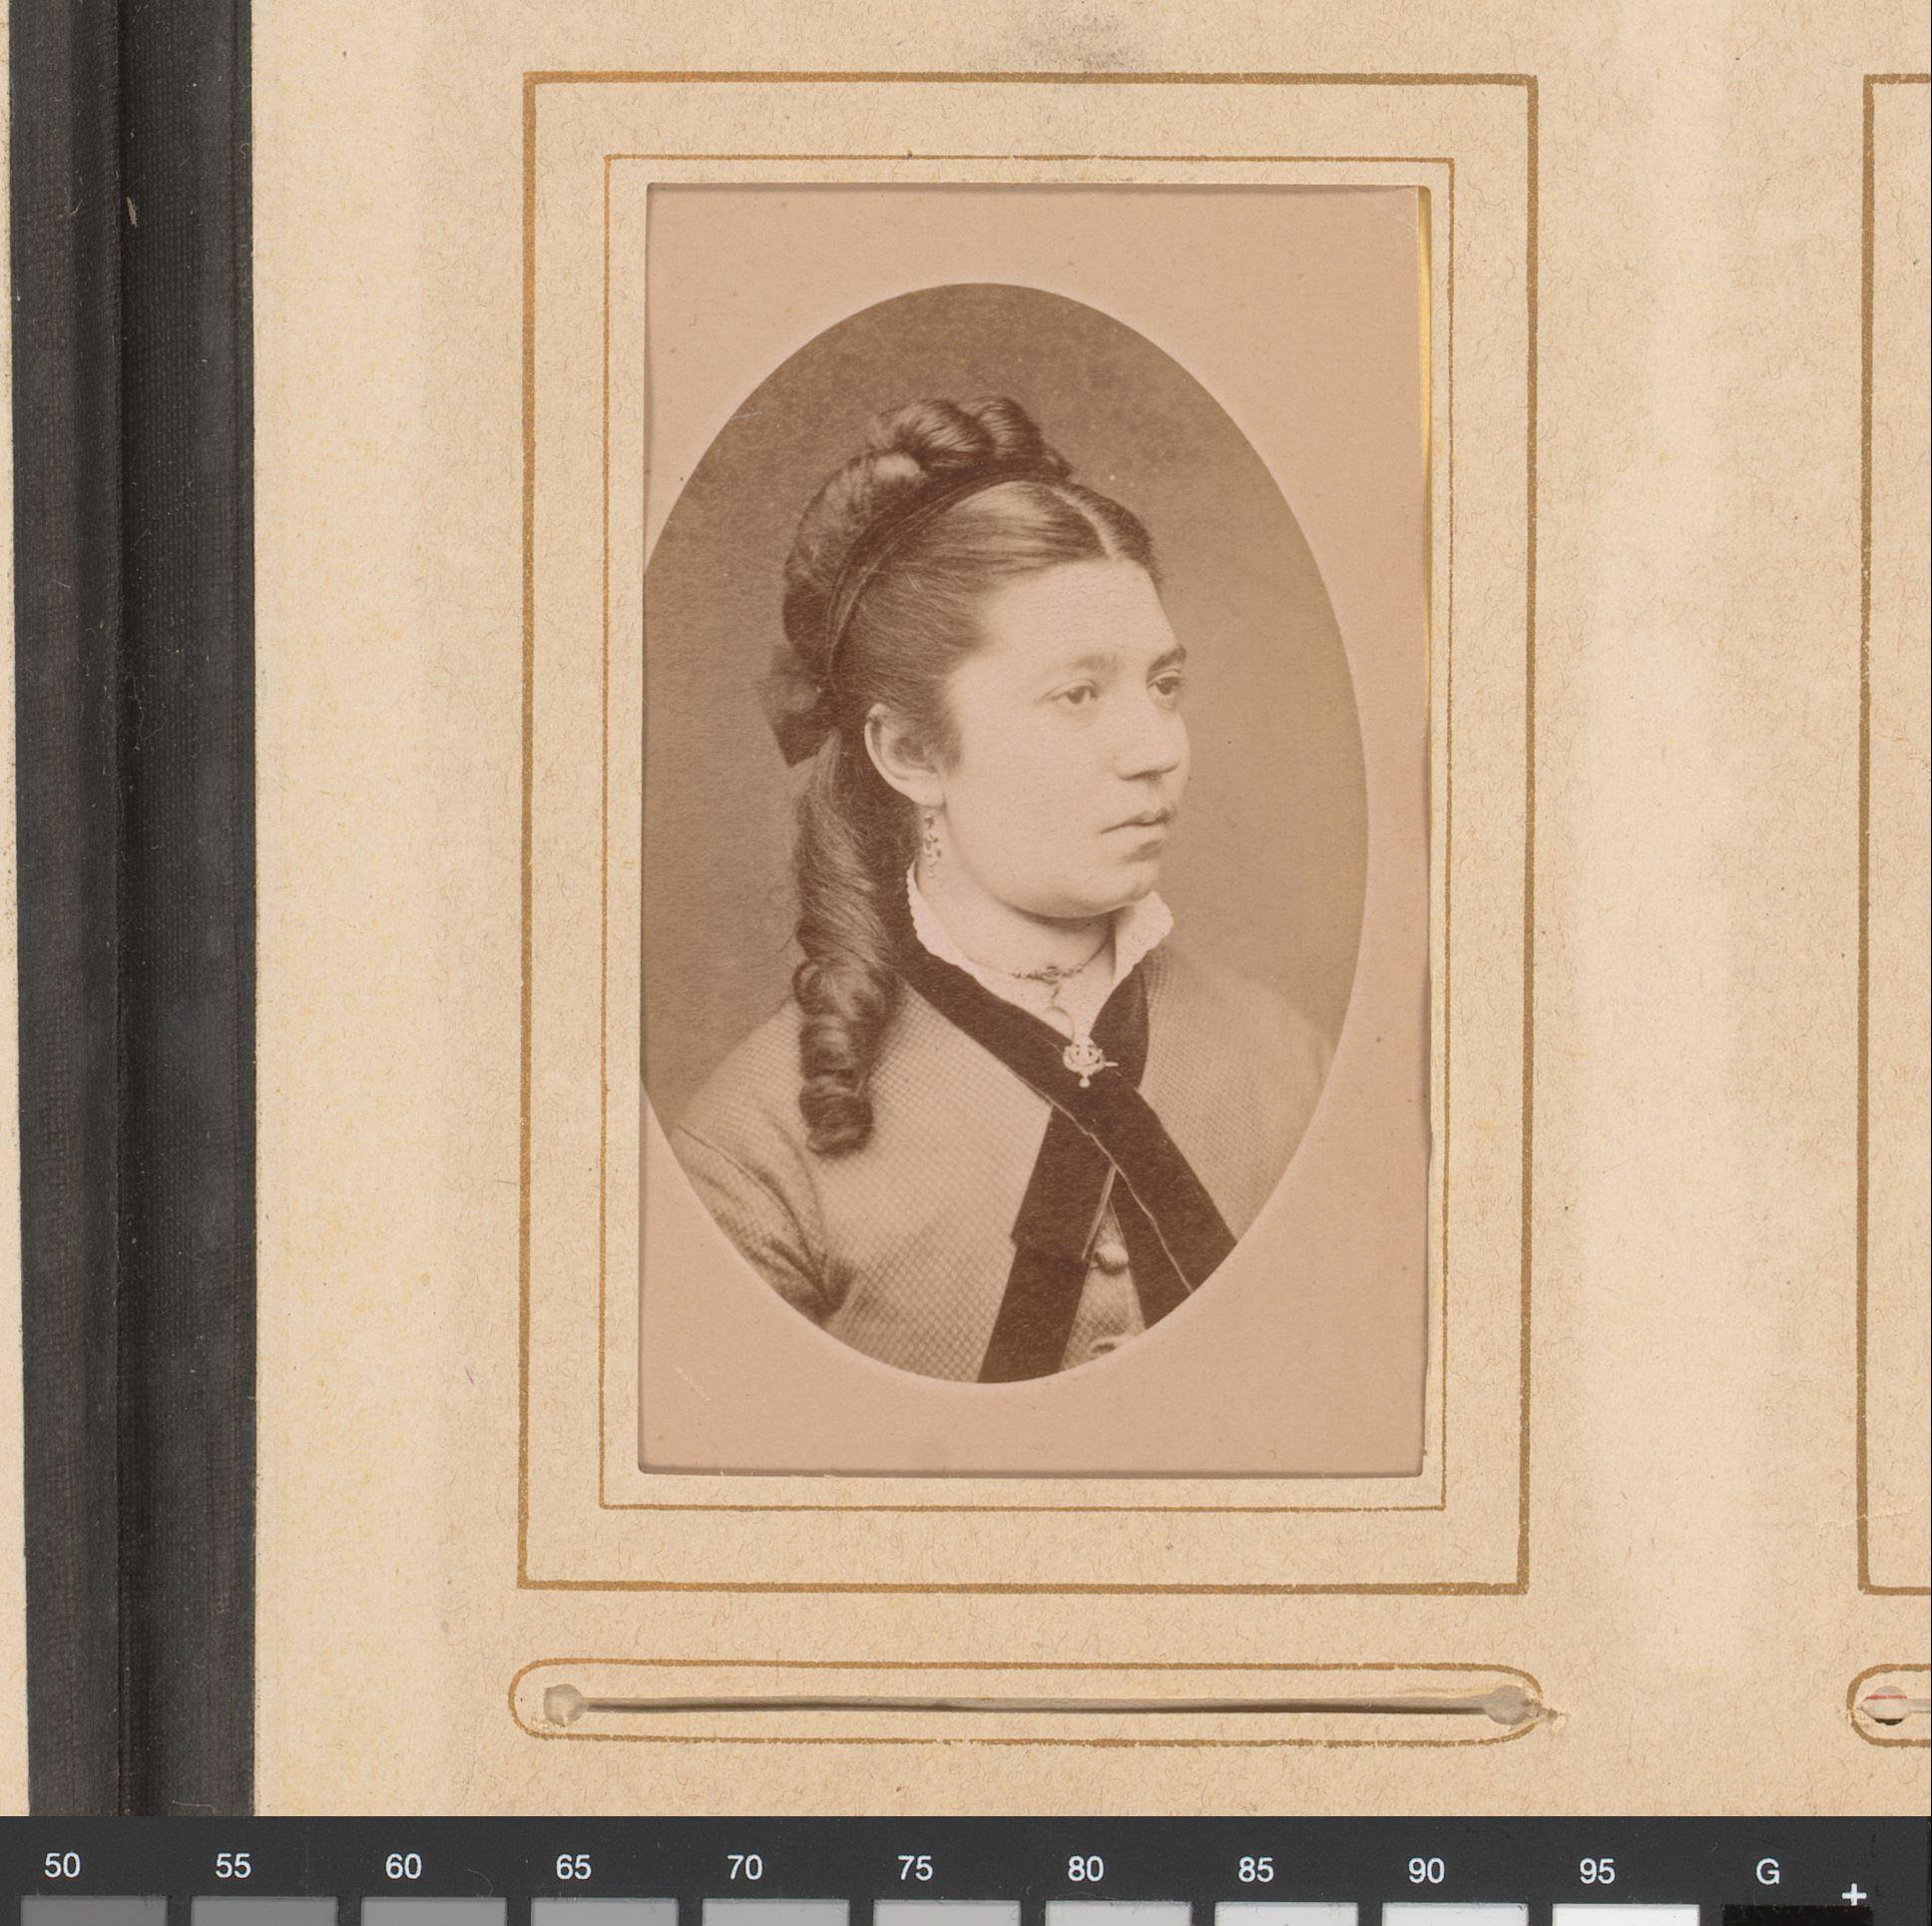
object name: photograph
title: Portret van een vrouw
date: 1874-1884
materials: cardboard, photographic support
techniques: albumen print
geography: north holland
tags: historical persons - bb - woman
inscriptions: annotation: ‘taken. Sept. 10th 1878/ age 1 year. 2 weeks’, inscription: ‘Atelier de Rembrant/ van/ P. Vlaanderen & C. van der Aa/ verdronken Oord/ Alkmaar/ Kanaalweg tegenover Tivolie/ Helder’